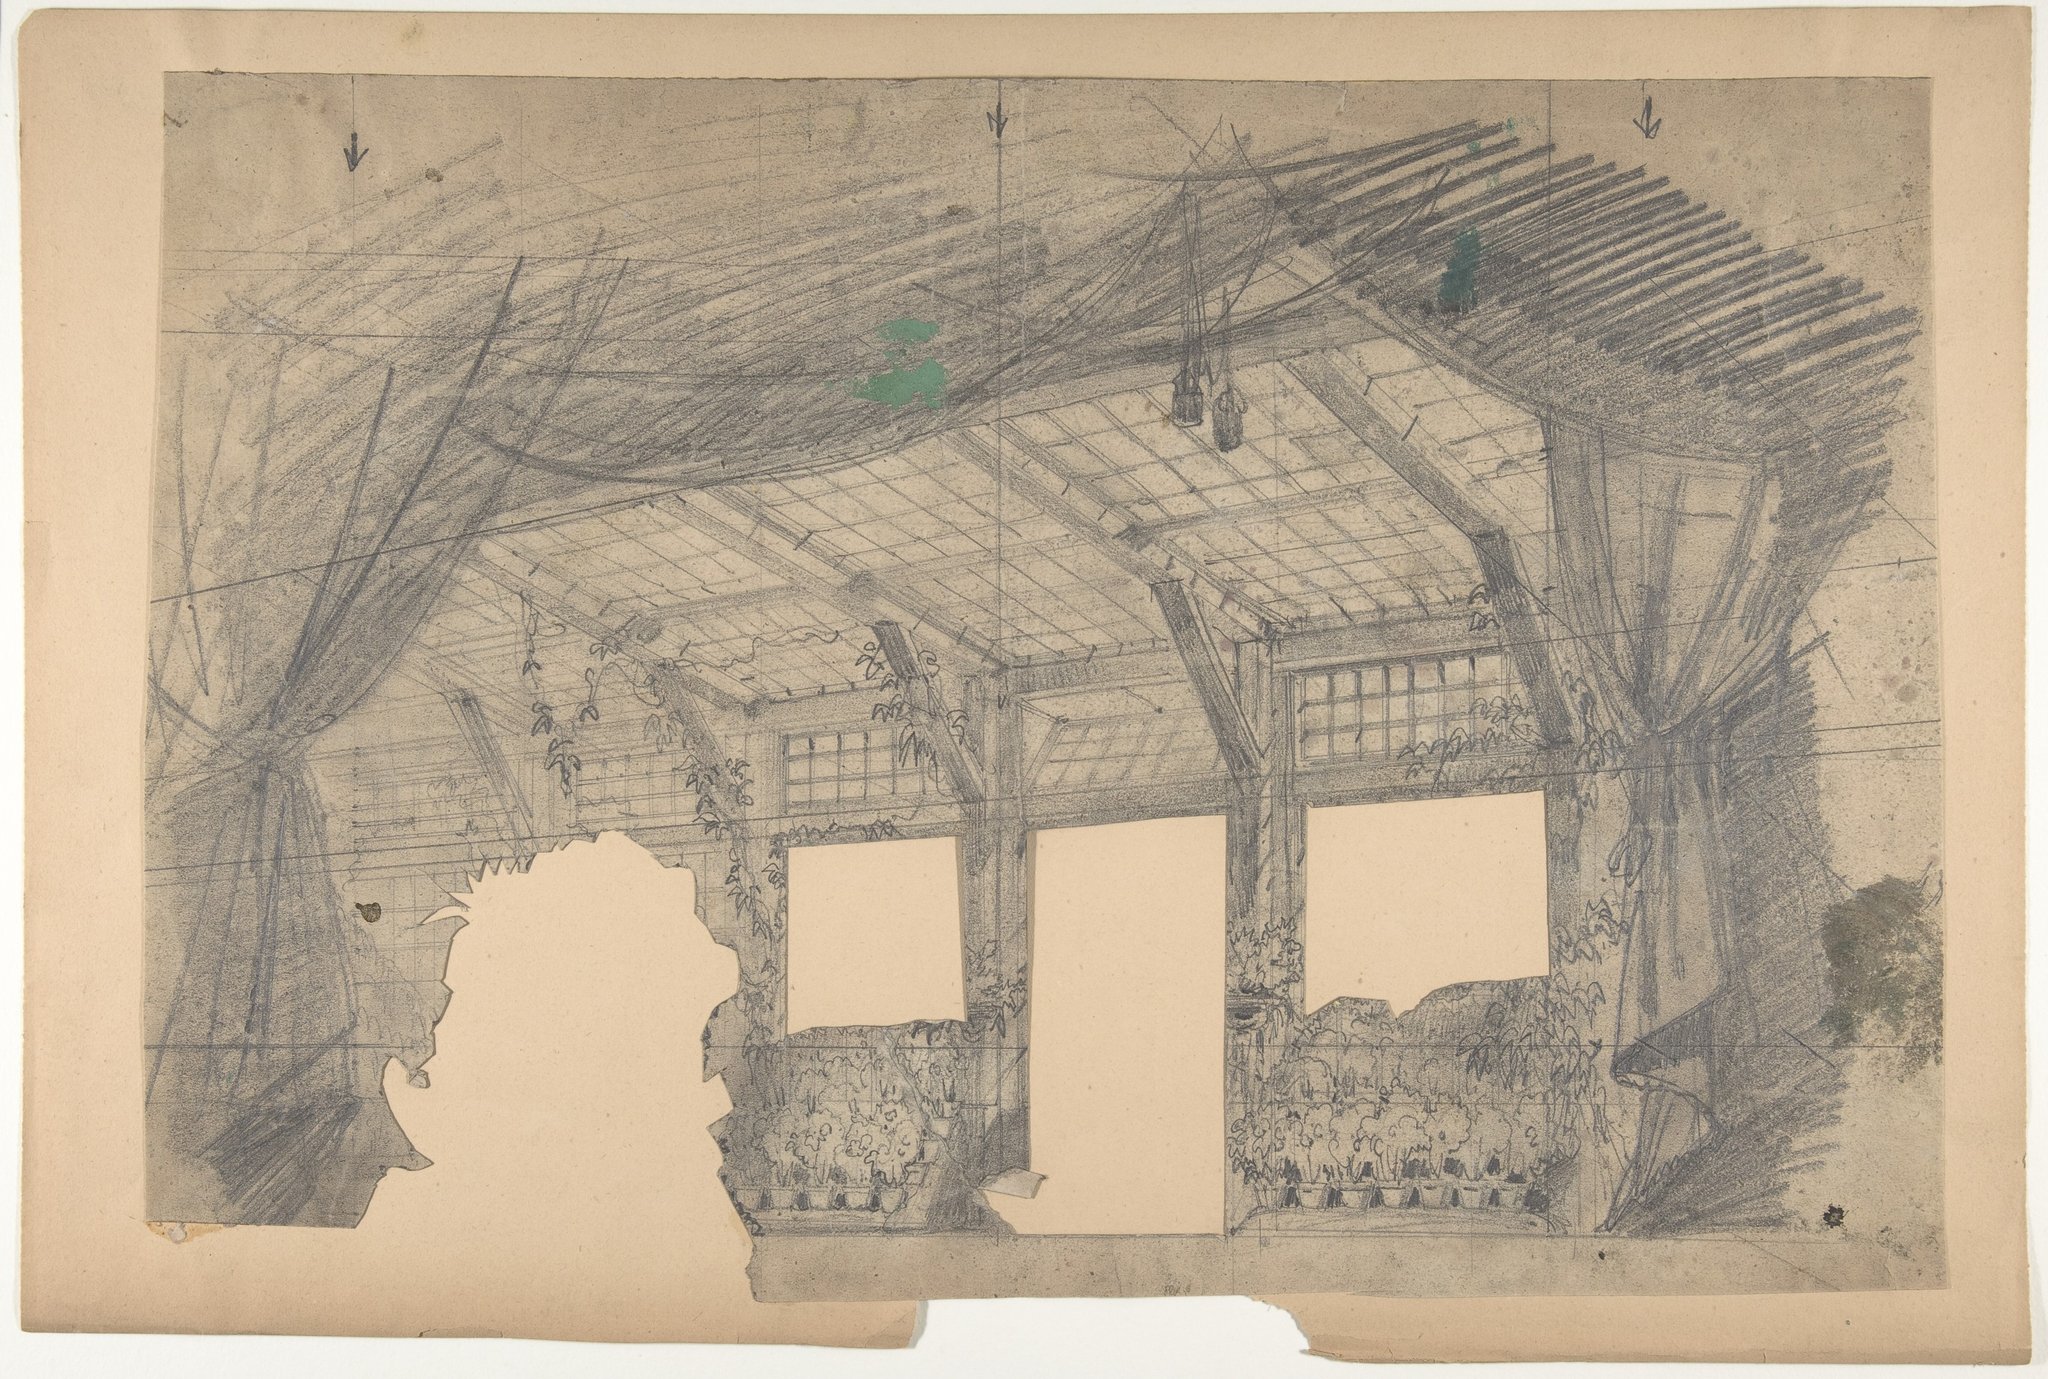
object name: drawing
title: Design for a Stage Set at the Opéra, Paris: a Greenhouse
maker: eugène cicéri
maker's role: artist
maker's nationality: french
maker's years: 1813-1890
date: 1828-1890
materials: graphite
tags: stage design